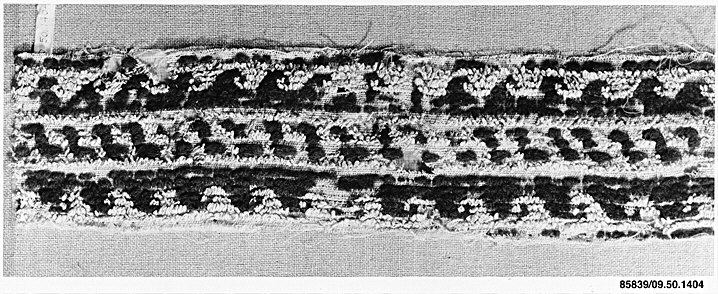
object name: textile fragment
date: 301-500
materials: linen, wool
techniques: embroidery, weave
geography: egypt